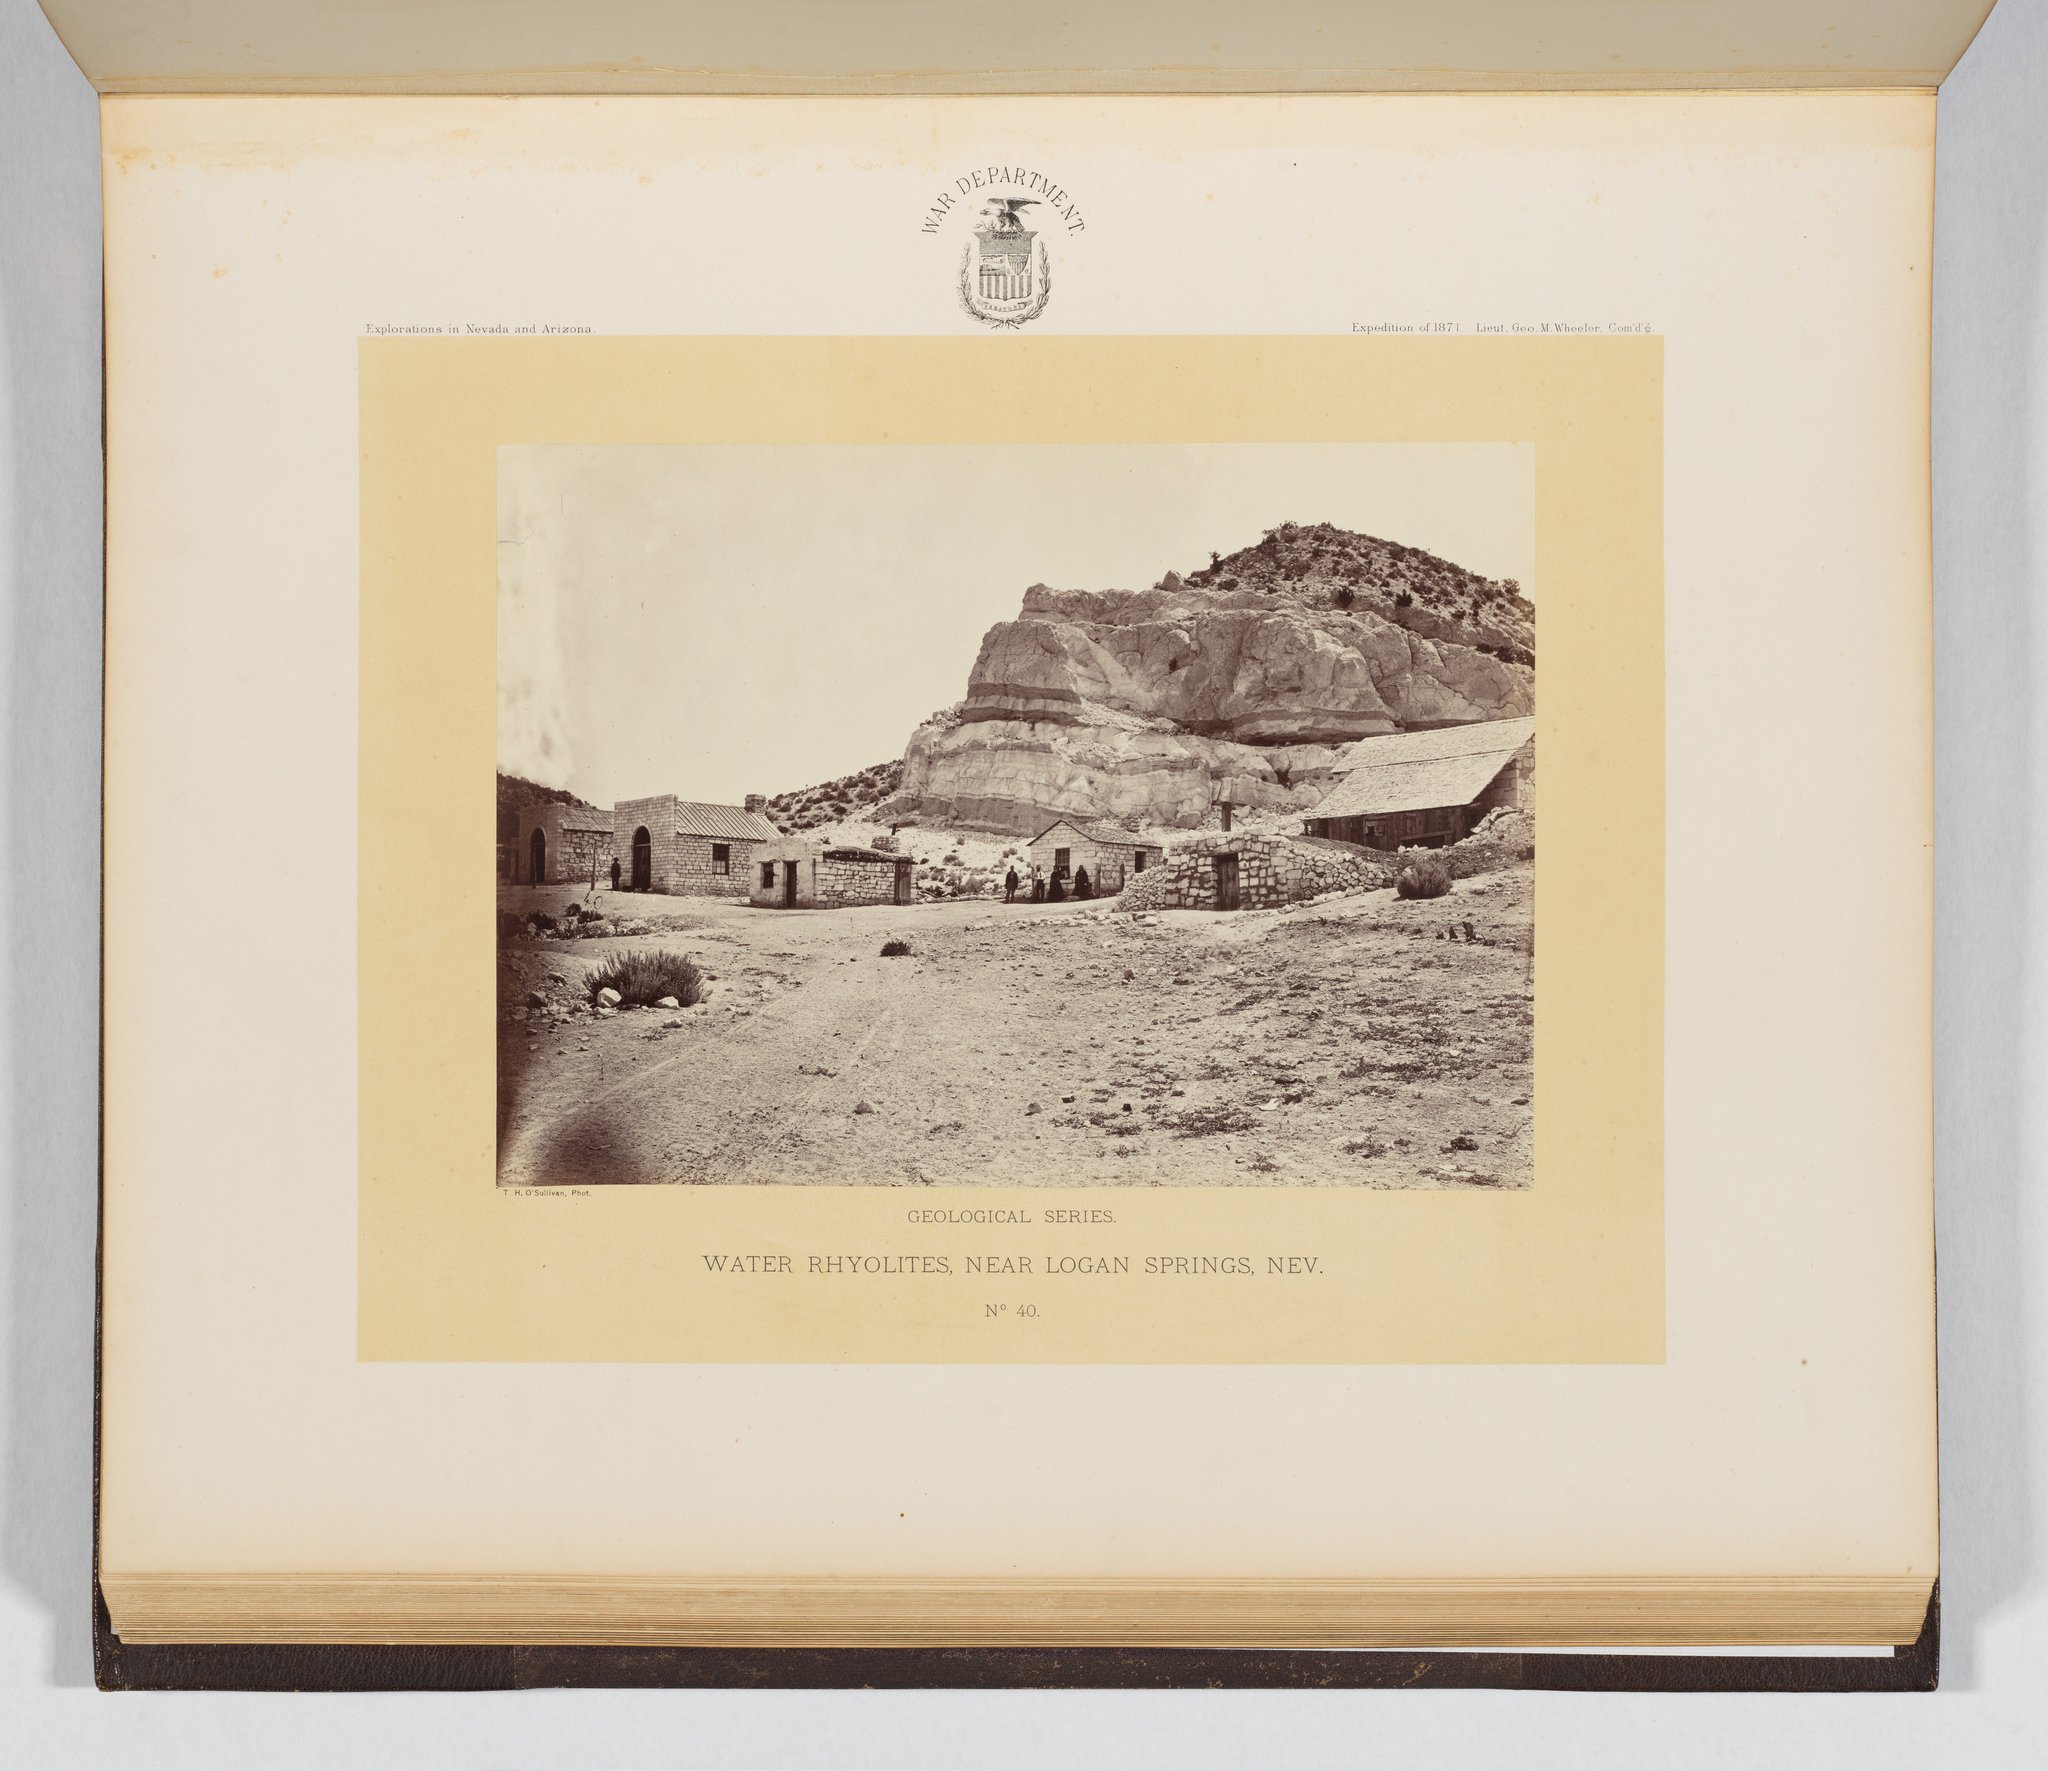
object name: photograph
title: Water Rhyolites, Near Logan Springs, Nevada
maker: timothy h. o'sullivan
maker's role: artist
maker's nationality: american, born ireland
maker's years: 1840-1882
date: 1871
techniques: albumen silver print, glass negative